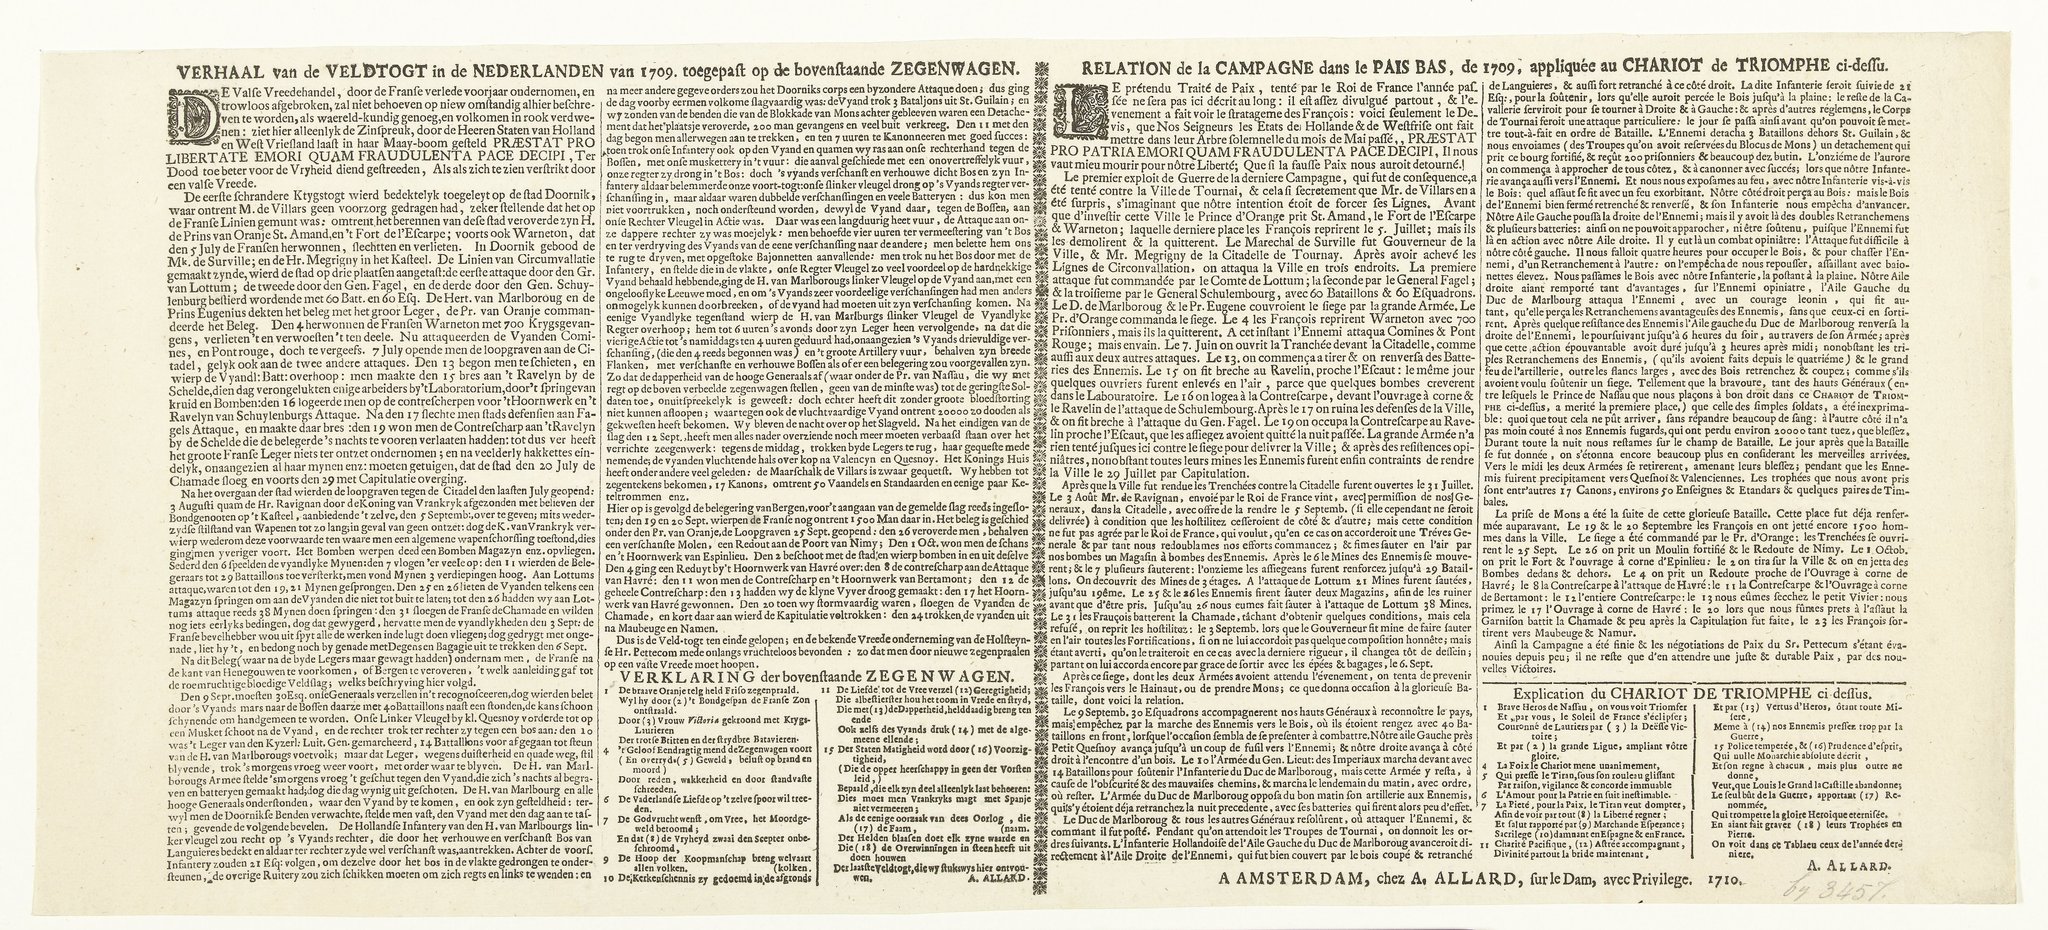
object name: text sheet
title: Neerlands Zegen Wagen, pralende met de Krygslauren van 't jaar 1709 tot 1710 / Chariot de Triomphe des Pais Bas (...)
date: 1710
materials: paper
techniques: letterpress printing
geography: amsterdam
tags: johan willem friso (prins van oranje-nassau)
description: Tekstblad bij de allegorie ter ere van de overwinningen door de Republiek in het jaar 1709 met een beschrijving van de veldtocht in de Nederlanden in 1709 in het Nederlands en Frans, met een verklaring van de cijfers 1-15 in de voorstelling